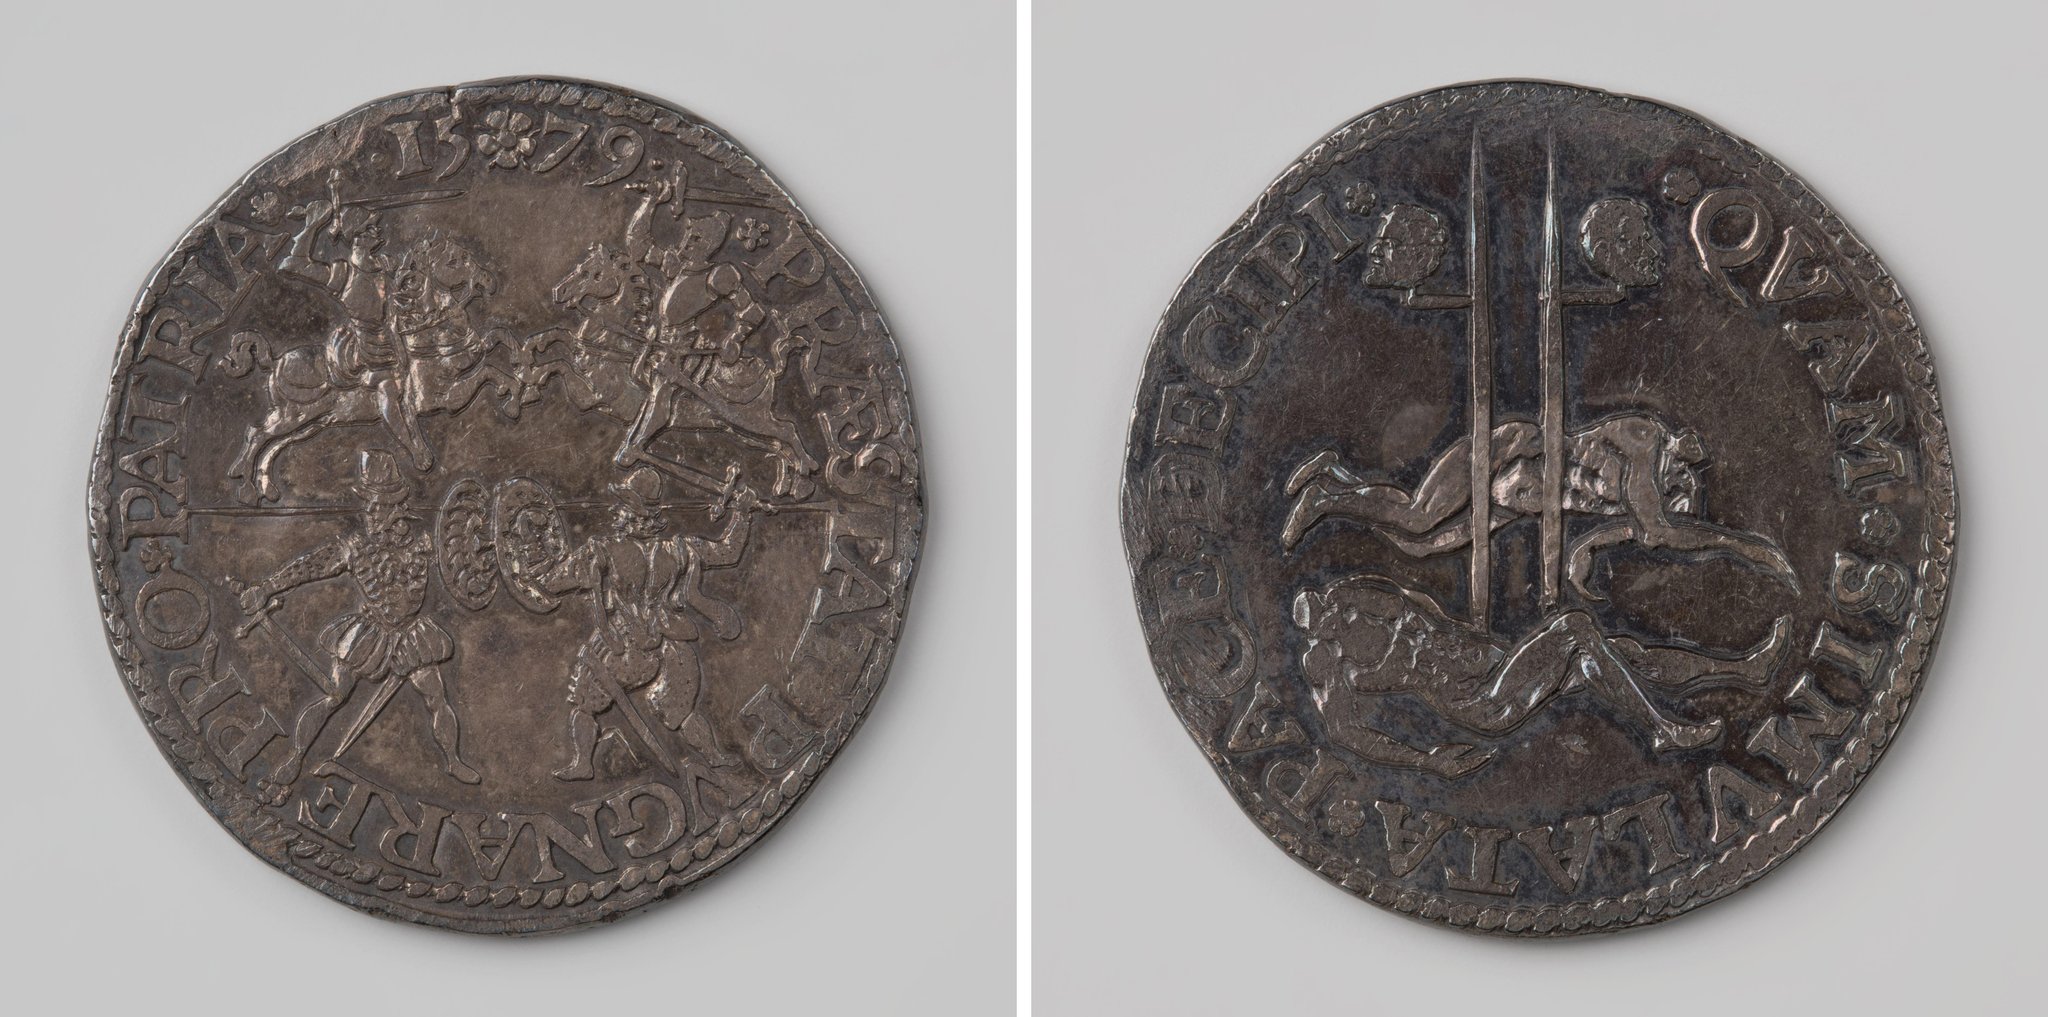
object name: history medal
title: Waarschuwing tegen de vredesonderhandelingen te Keulen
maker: gerard van bylaer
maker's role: die cutter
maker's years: 1540-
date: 1579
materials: silver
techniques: striking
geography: dordrecht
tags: brussels, earl, cologne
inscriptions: circumscription: ‘QVAM SIMVLATA PACE DECIPI’, circumscription: ‘PRAESTAT PVGNARE PRO PATRIA 1579’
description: Zilveren penning. Voorzijde: twee ruiters en twee soldaten te voet met elkaar in gevecht binnen omschrift. Keerzijde: twee lijken, waarvan de hoofden op staken zijn geplaatst binnen omschrift.